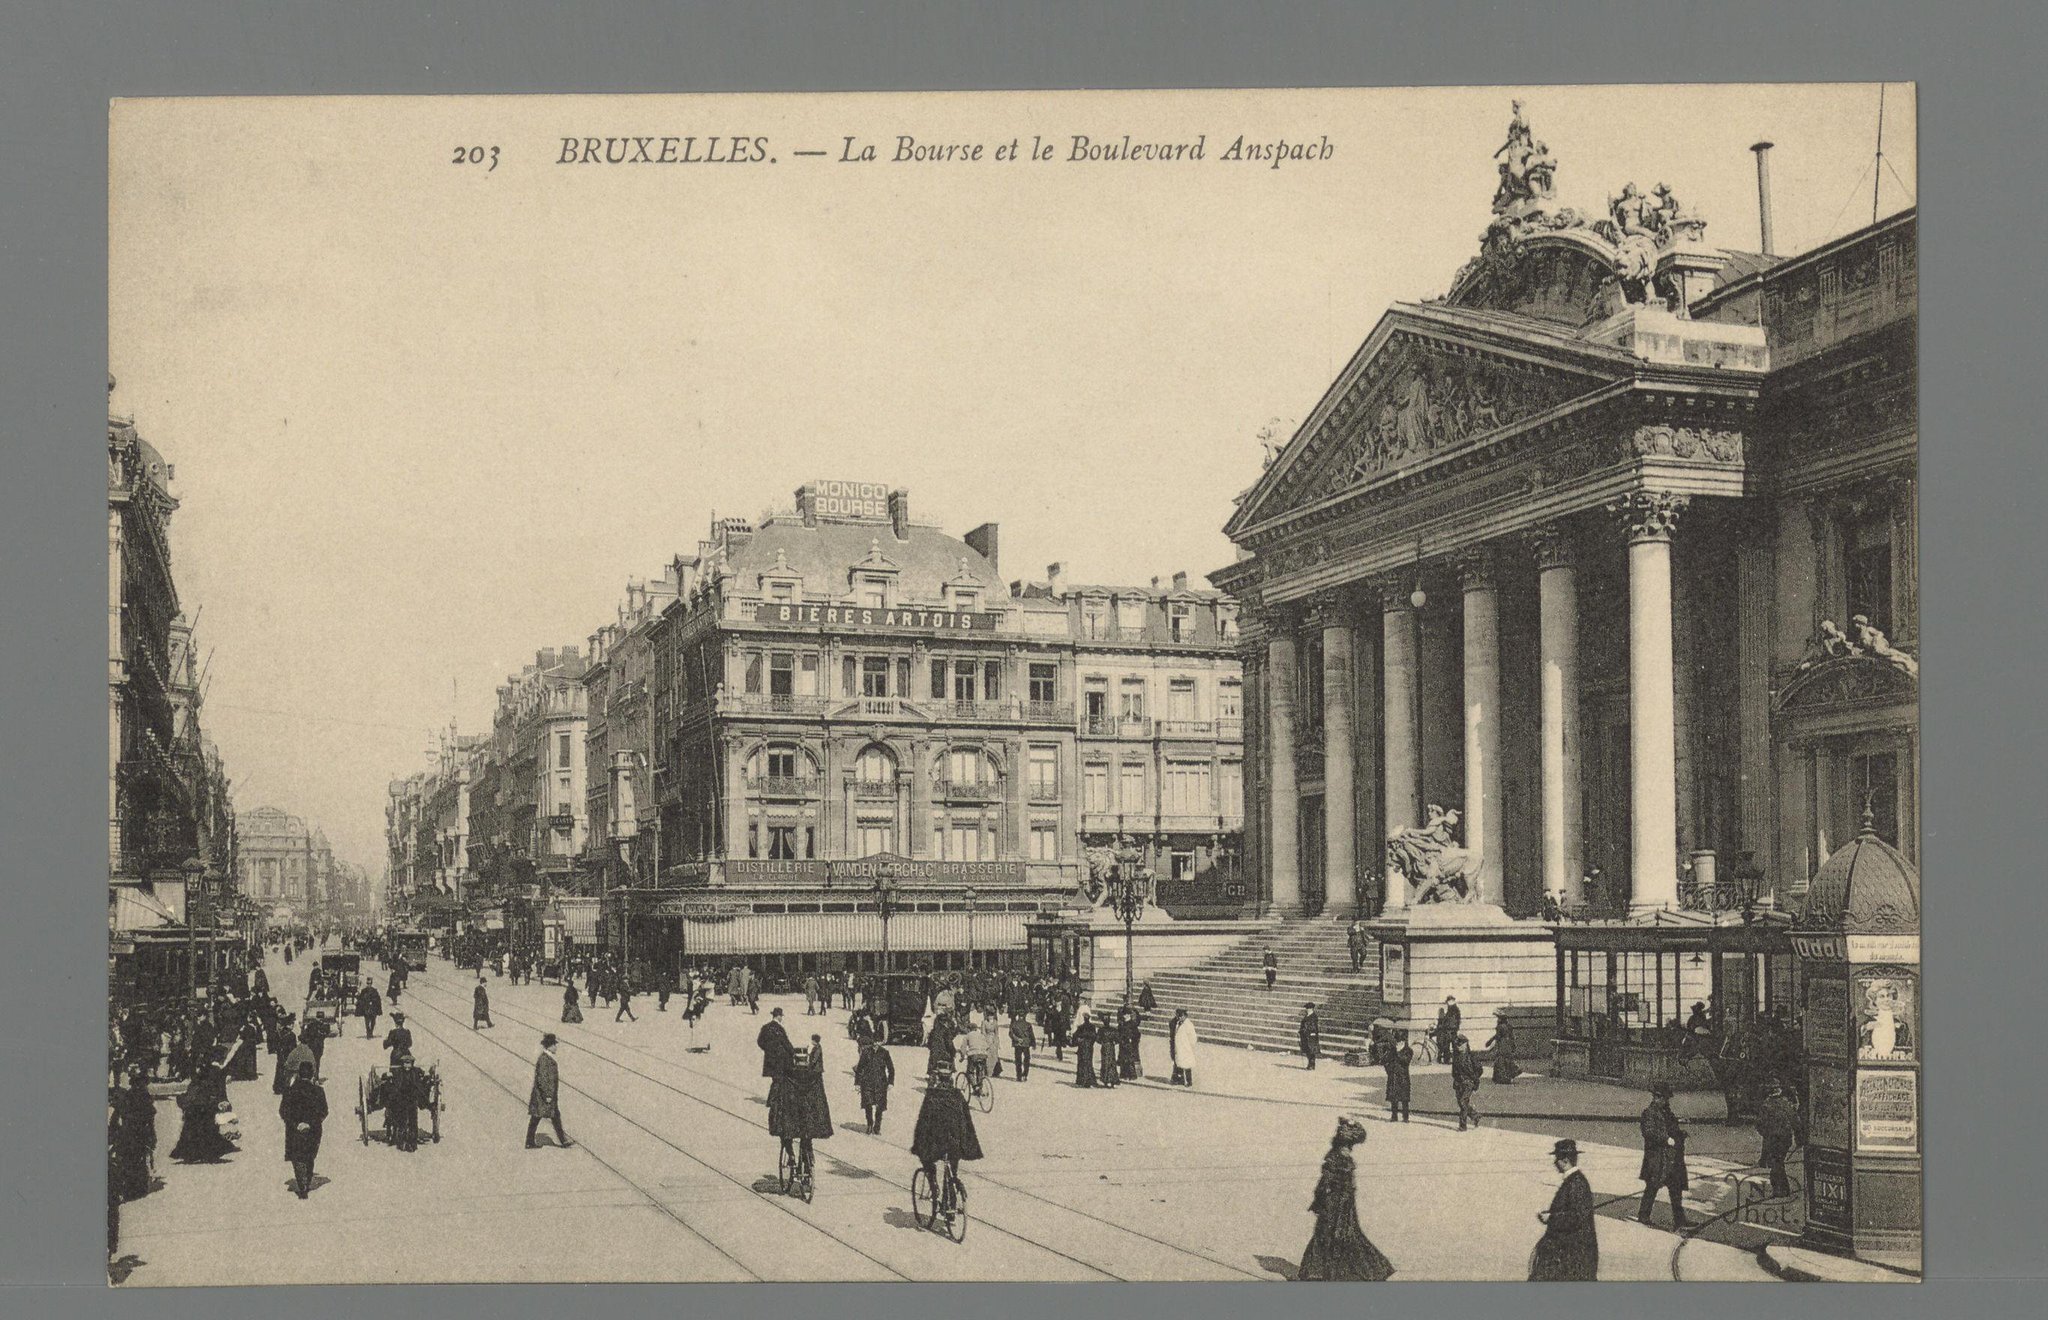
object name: ansichtkaart, prentbriefkaart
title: Bruxelles. La Bourse et le Boulevard Anspach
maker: Anonymous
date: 1906-1918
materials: cardboard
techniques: photograph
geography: paris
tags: exchange, bourse, city-view, and landscape with man-made constructions (+ city(-scape) with figures, staffage)